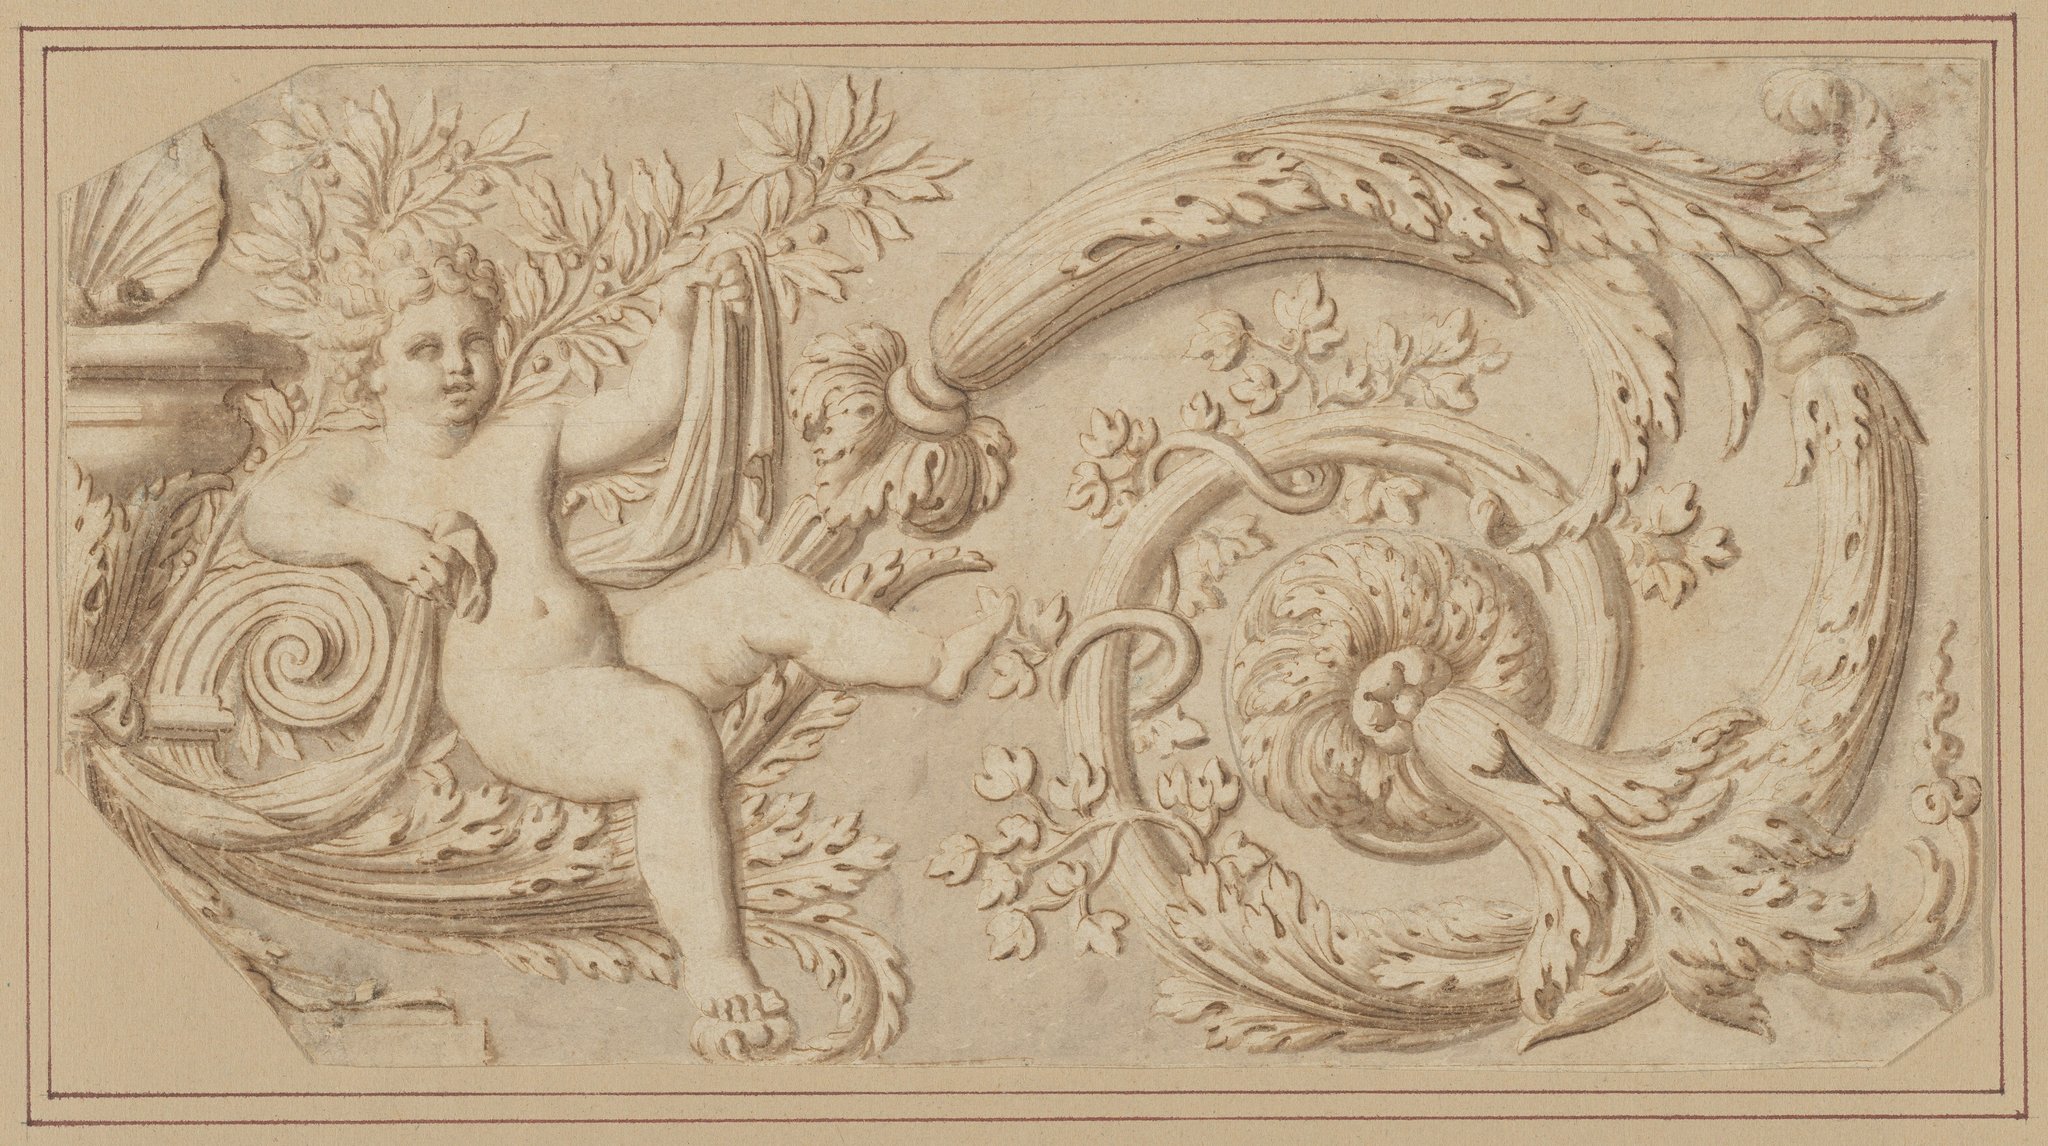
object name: drawing ornament architecture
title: Design for a Frieze with Putto and Acanthus Scroll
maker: anonymous, french, 17th century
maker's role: artist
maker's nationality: french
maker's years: 1600-1700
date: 1601-1700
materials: ink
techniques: pen, wash